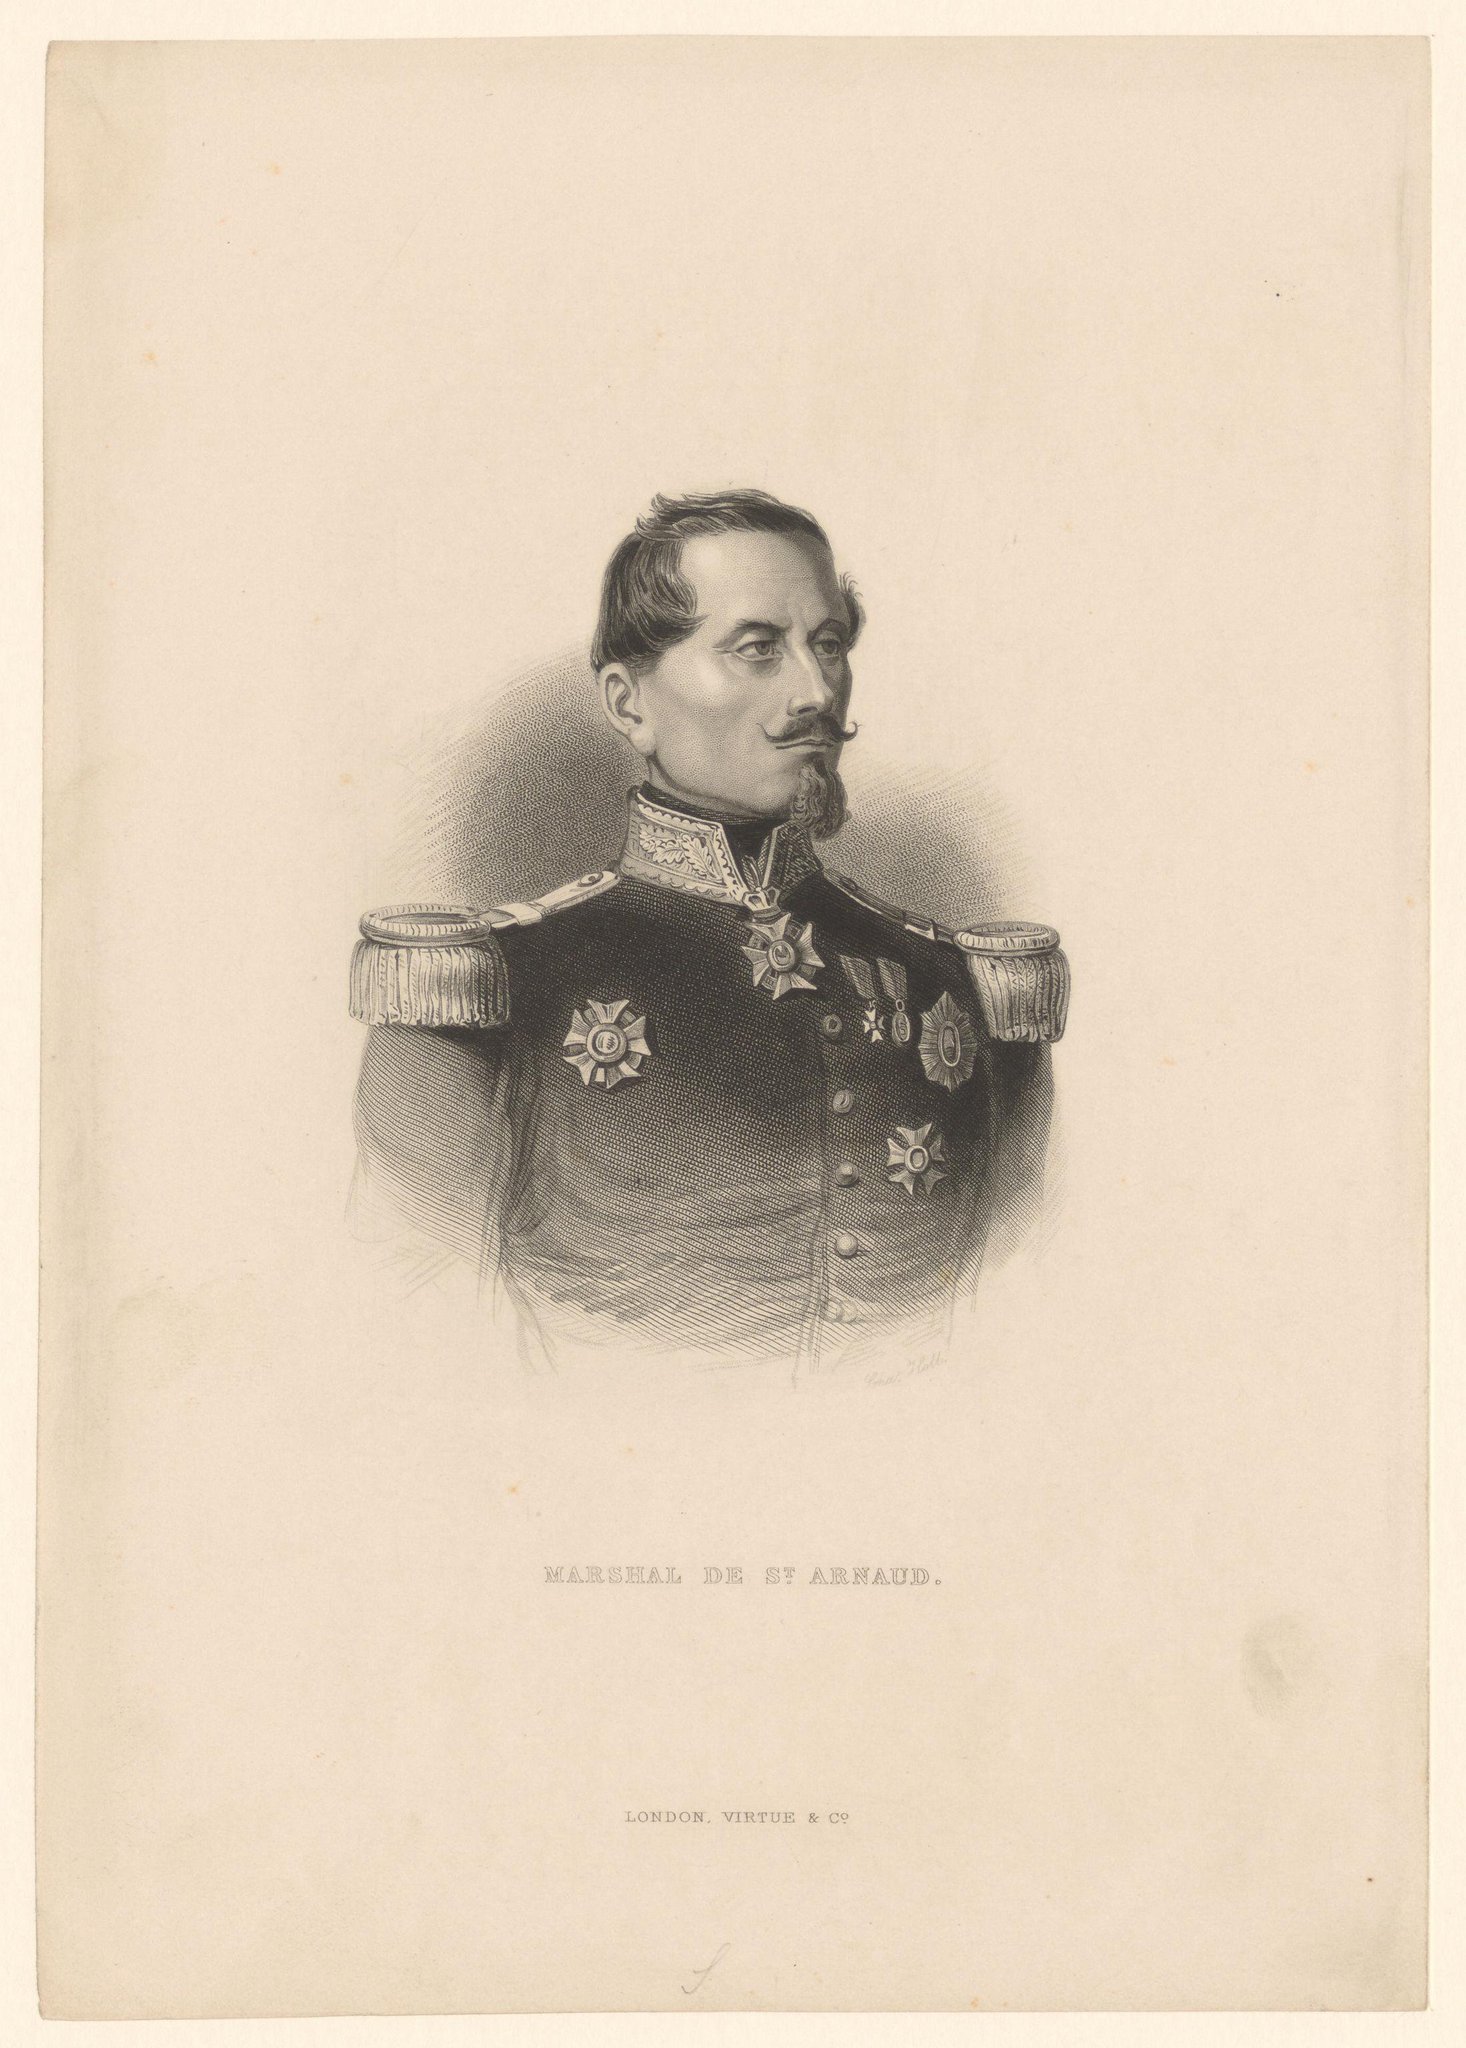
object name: print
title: Portret van Armand Jacques Leroy de Saint-Arnaud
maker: charles holl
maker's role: print maker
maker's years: 1820-1882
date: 1830-1882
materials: paper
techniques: engraving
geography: london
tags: historical persons, officer, medals and other marks of military honour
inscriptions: collector's mark: Lugt 2228